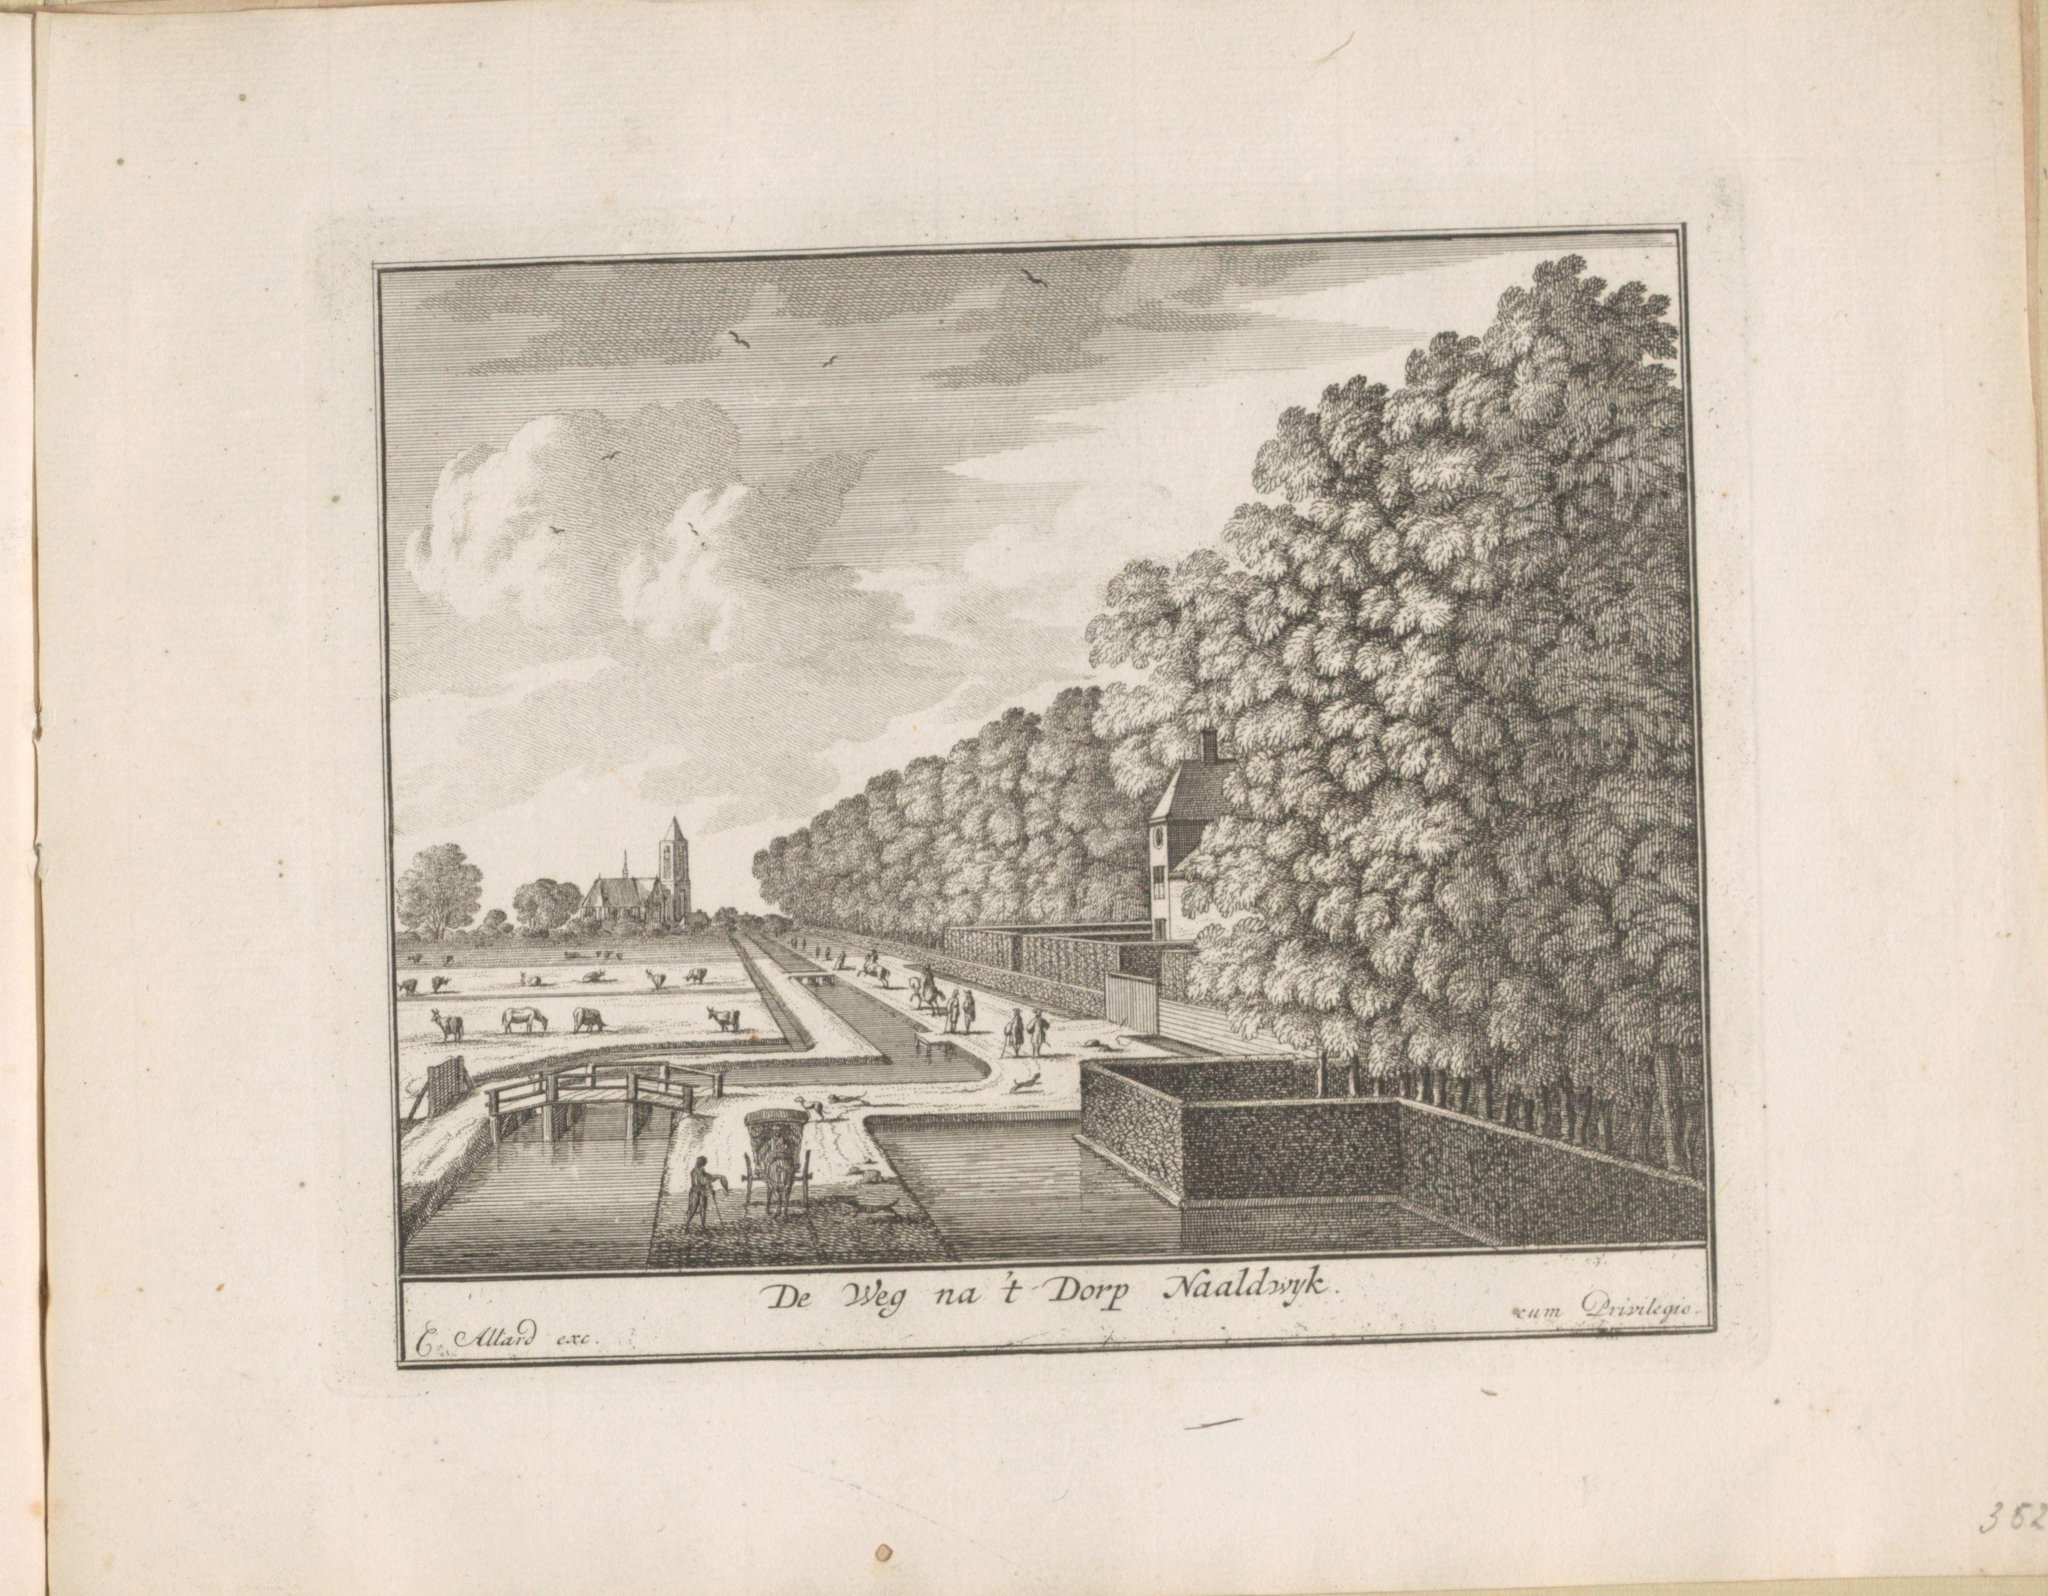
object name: album leaf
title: Hollands Lustpark besluitende zyn Britannische majesteits hof-gebouw tot Honslaardyk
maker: carel allard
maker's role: print maker, publisher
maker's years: 1648-1709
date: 1689-1702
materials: paper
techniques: etching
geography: amsterdam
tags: road, path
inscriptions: number: ‘352’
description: Weg langs een sloot met wandelaars, ruiters en rijtuigen. Rechts een bos, links weilanden met koeien, op de achtergrond de kerk van Naaldwijk. Prent maakt deel uit van een album.